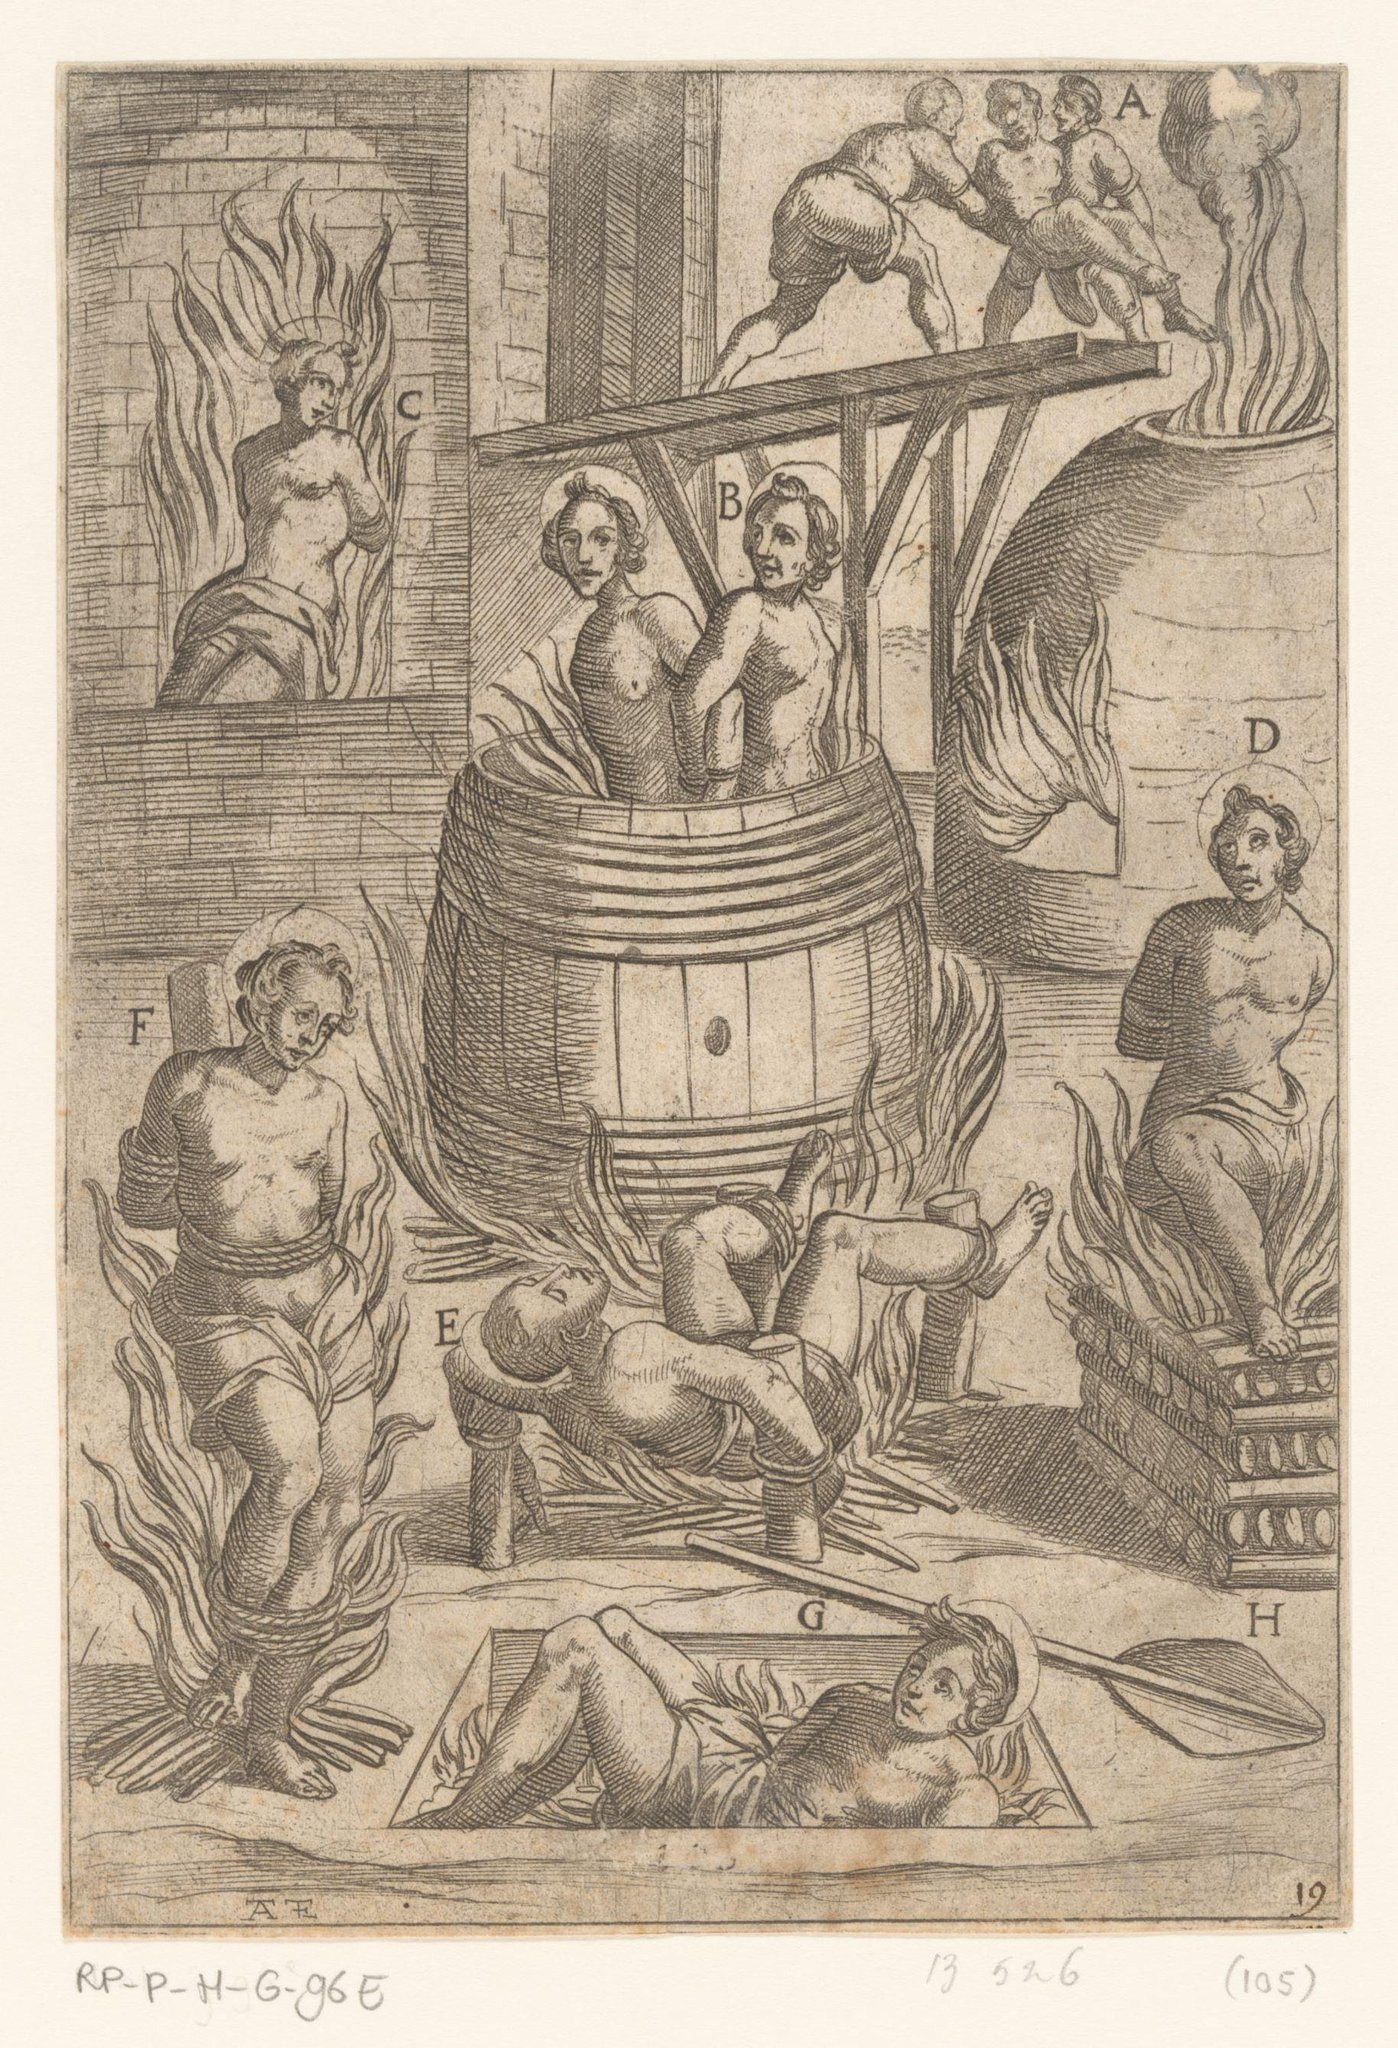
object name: print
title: Foltering door verschillende manieren van verbranden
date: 1565-1630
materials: paper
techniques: etching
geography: vatican city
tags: violent death ~ maltreatment, torture, torture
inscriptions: number: ‘19’, collector's mark: Lugt 11, collector's mark: ‘Hinloopen’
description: Deze prent maakt deel uit van een reeks van 47 prenten (+ titelprent) met voorstellingen van martelmethoden. Deze prenten zijn in een andere editie gebruikt als illustraties voor Antonio Gallonio's 'Trattato degli Instrumenti di Martirio e delle Varie Maniere di Martoriare Usate dai Gentili contro Christiani' (Rome, Ascanio en Girolamo Dongangeli, 1591). Midden onder nummer 105 weggekrast.